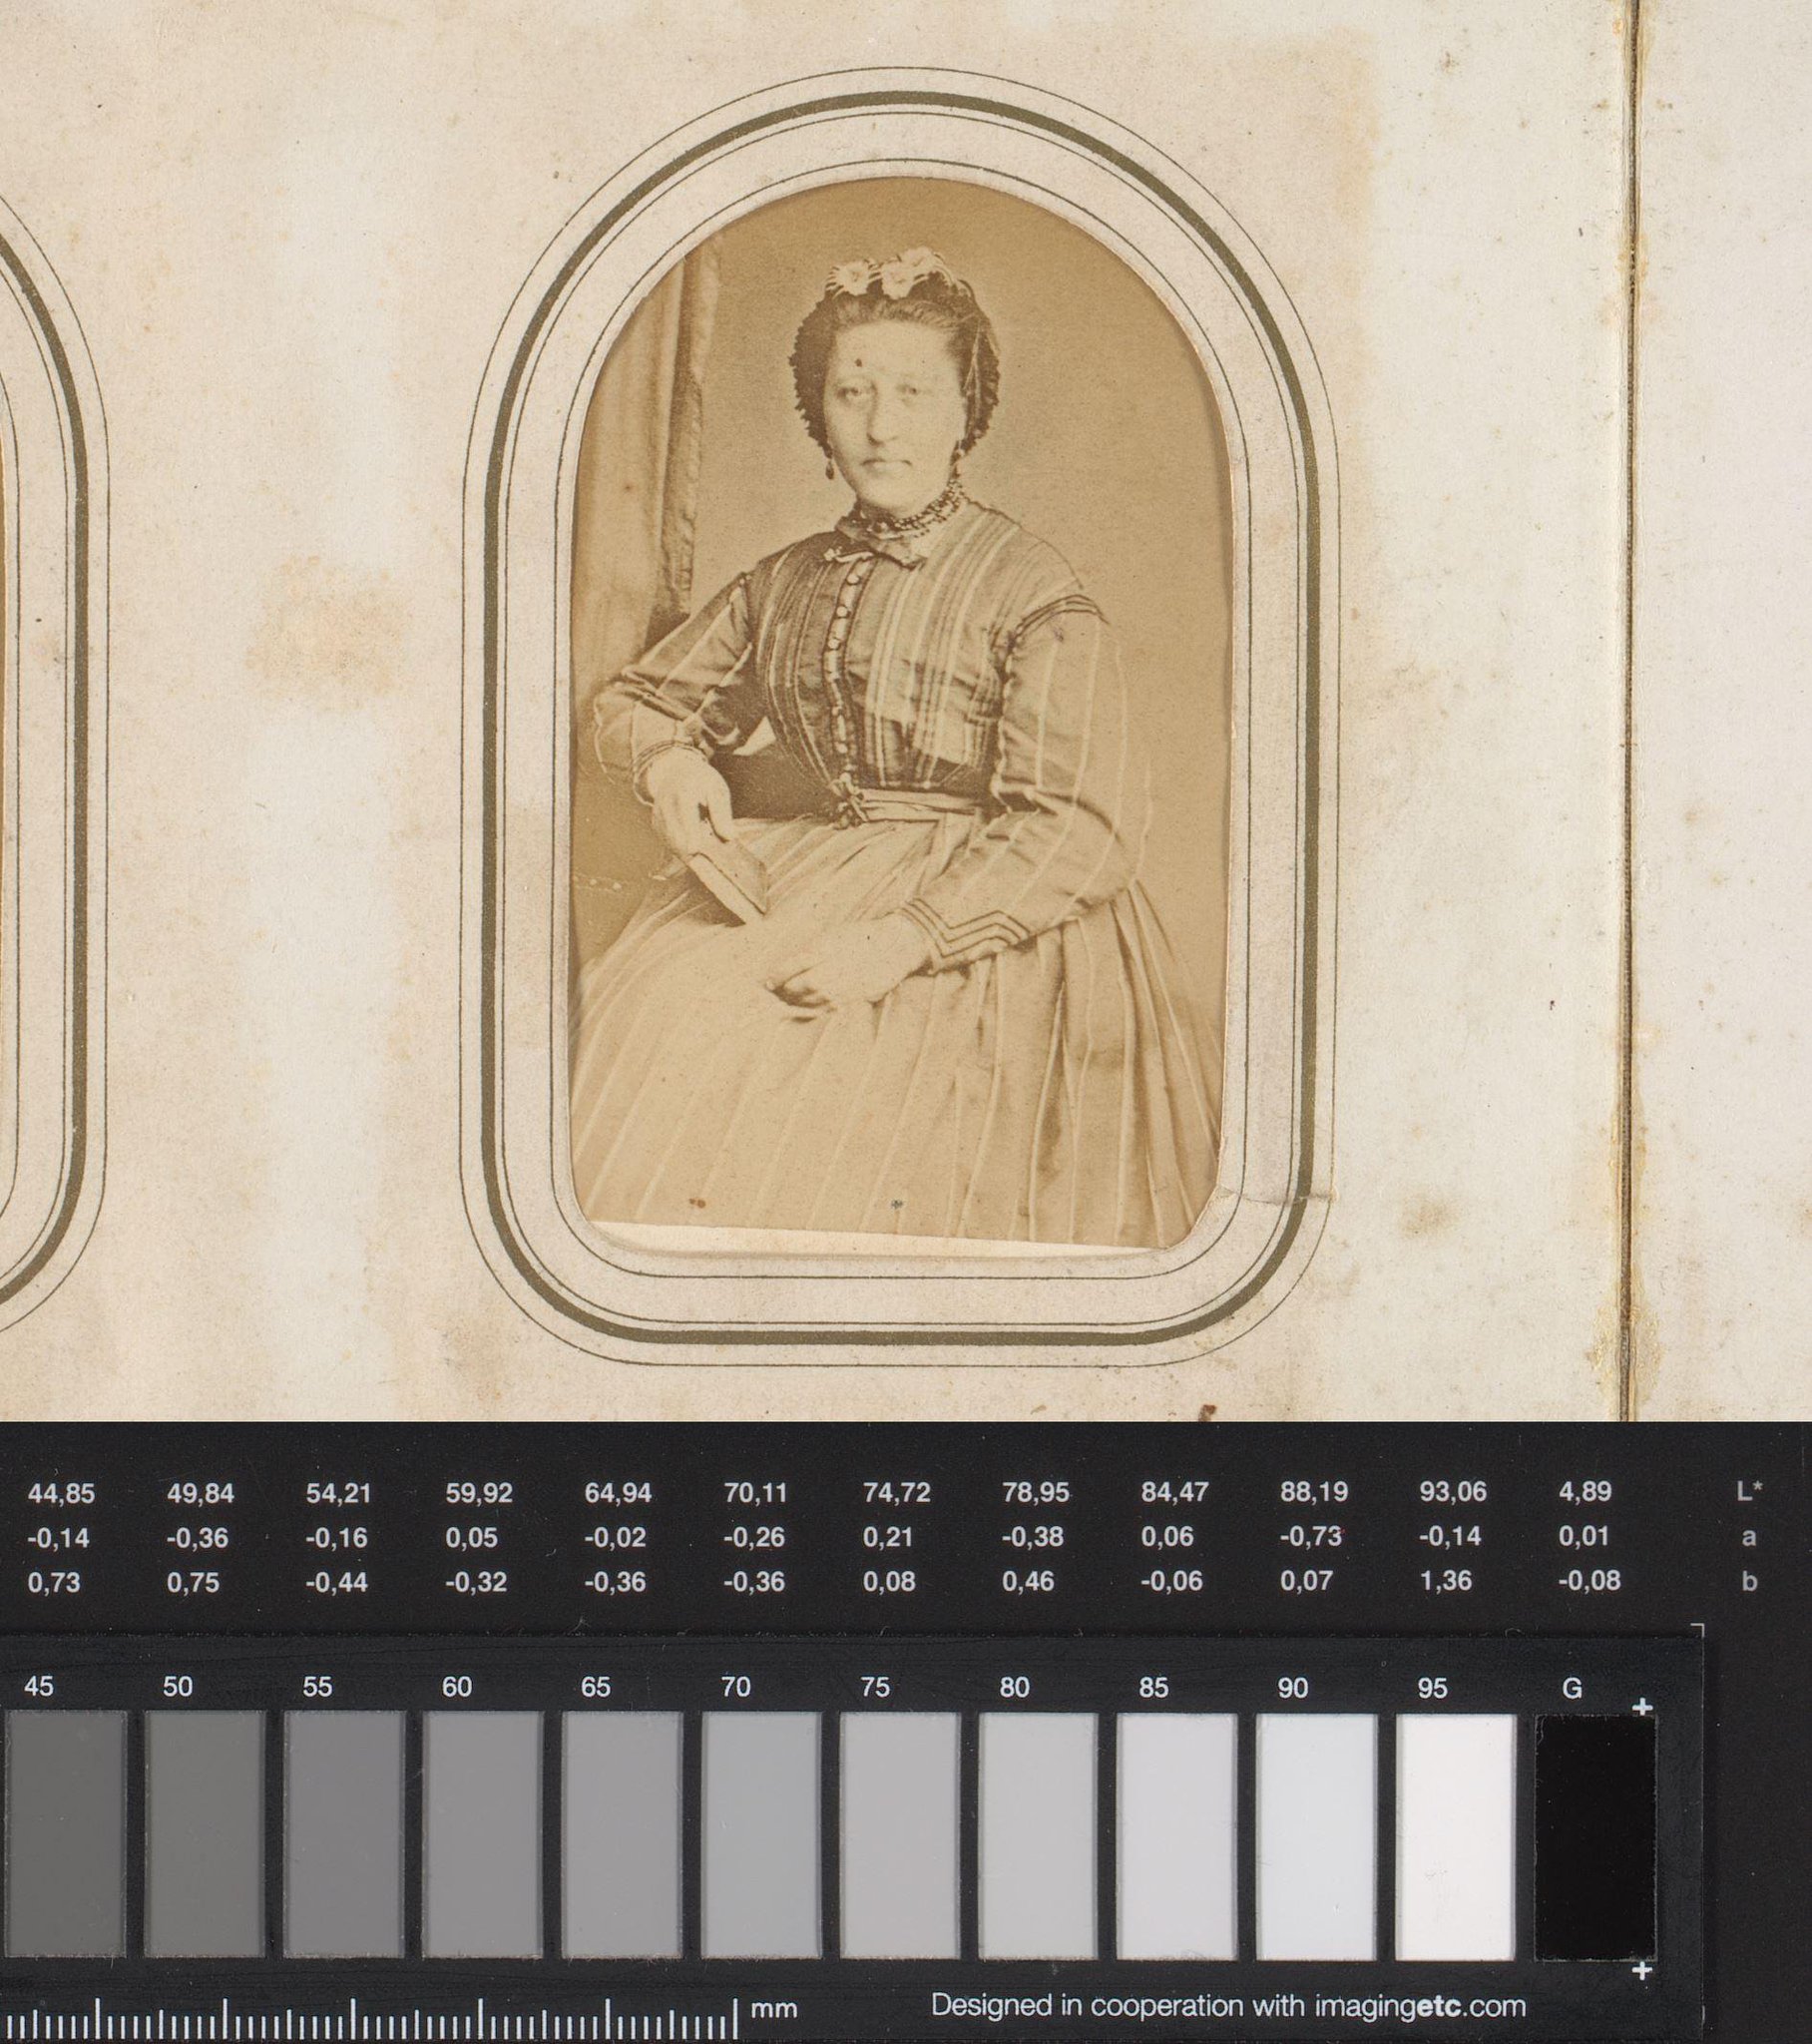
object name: carte de visite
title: Portret van een zittende vrouw met bloemen in het haar en een boek in de hand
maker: Anonymous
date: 1860-1880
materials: cardboard, photographic support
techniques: albumen print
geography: netherlands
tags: flowers, sitting figure - aa - female human figure, historical persons - bb - woman, book